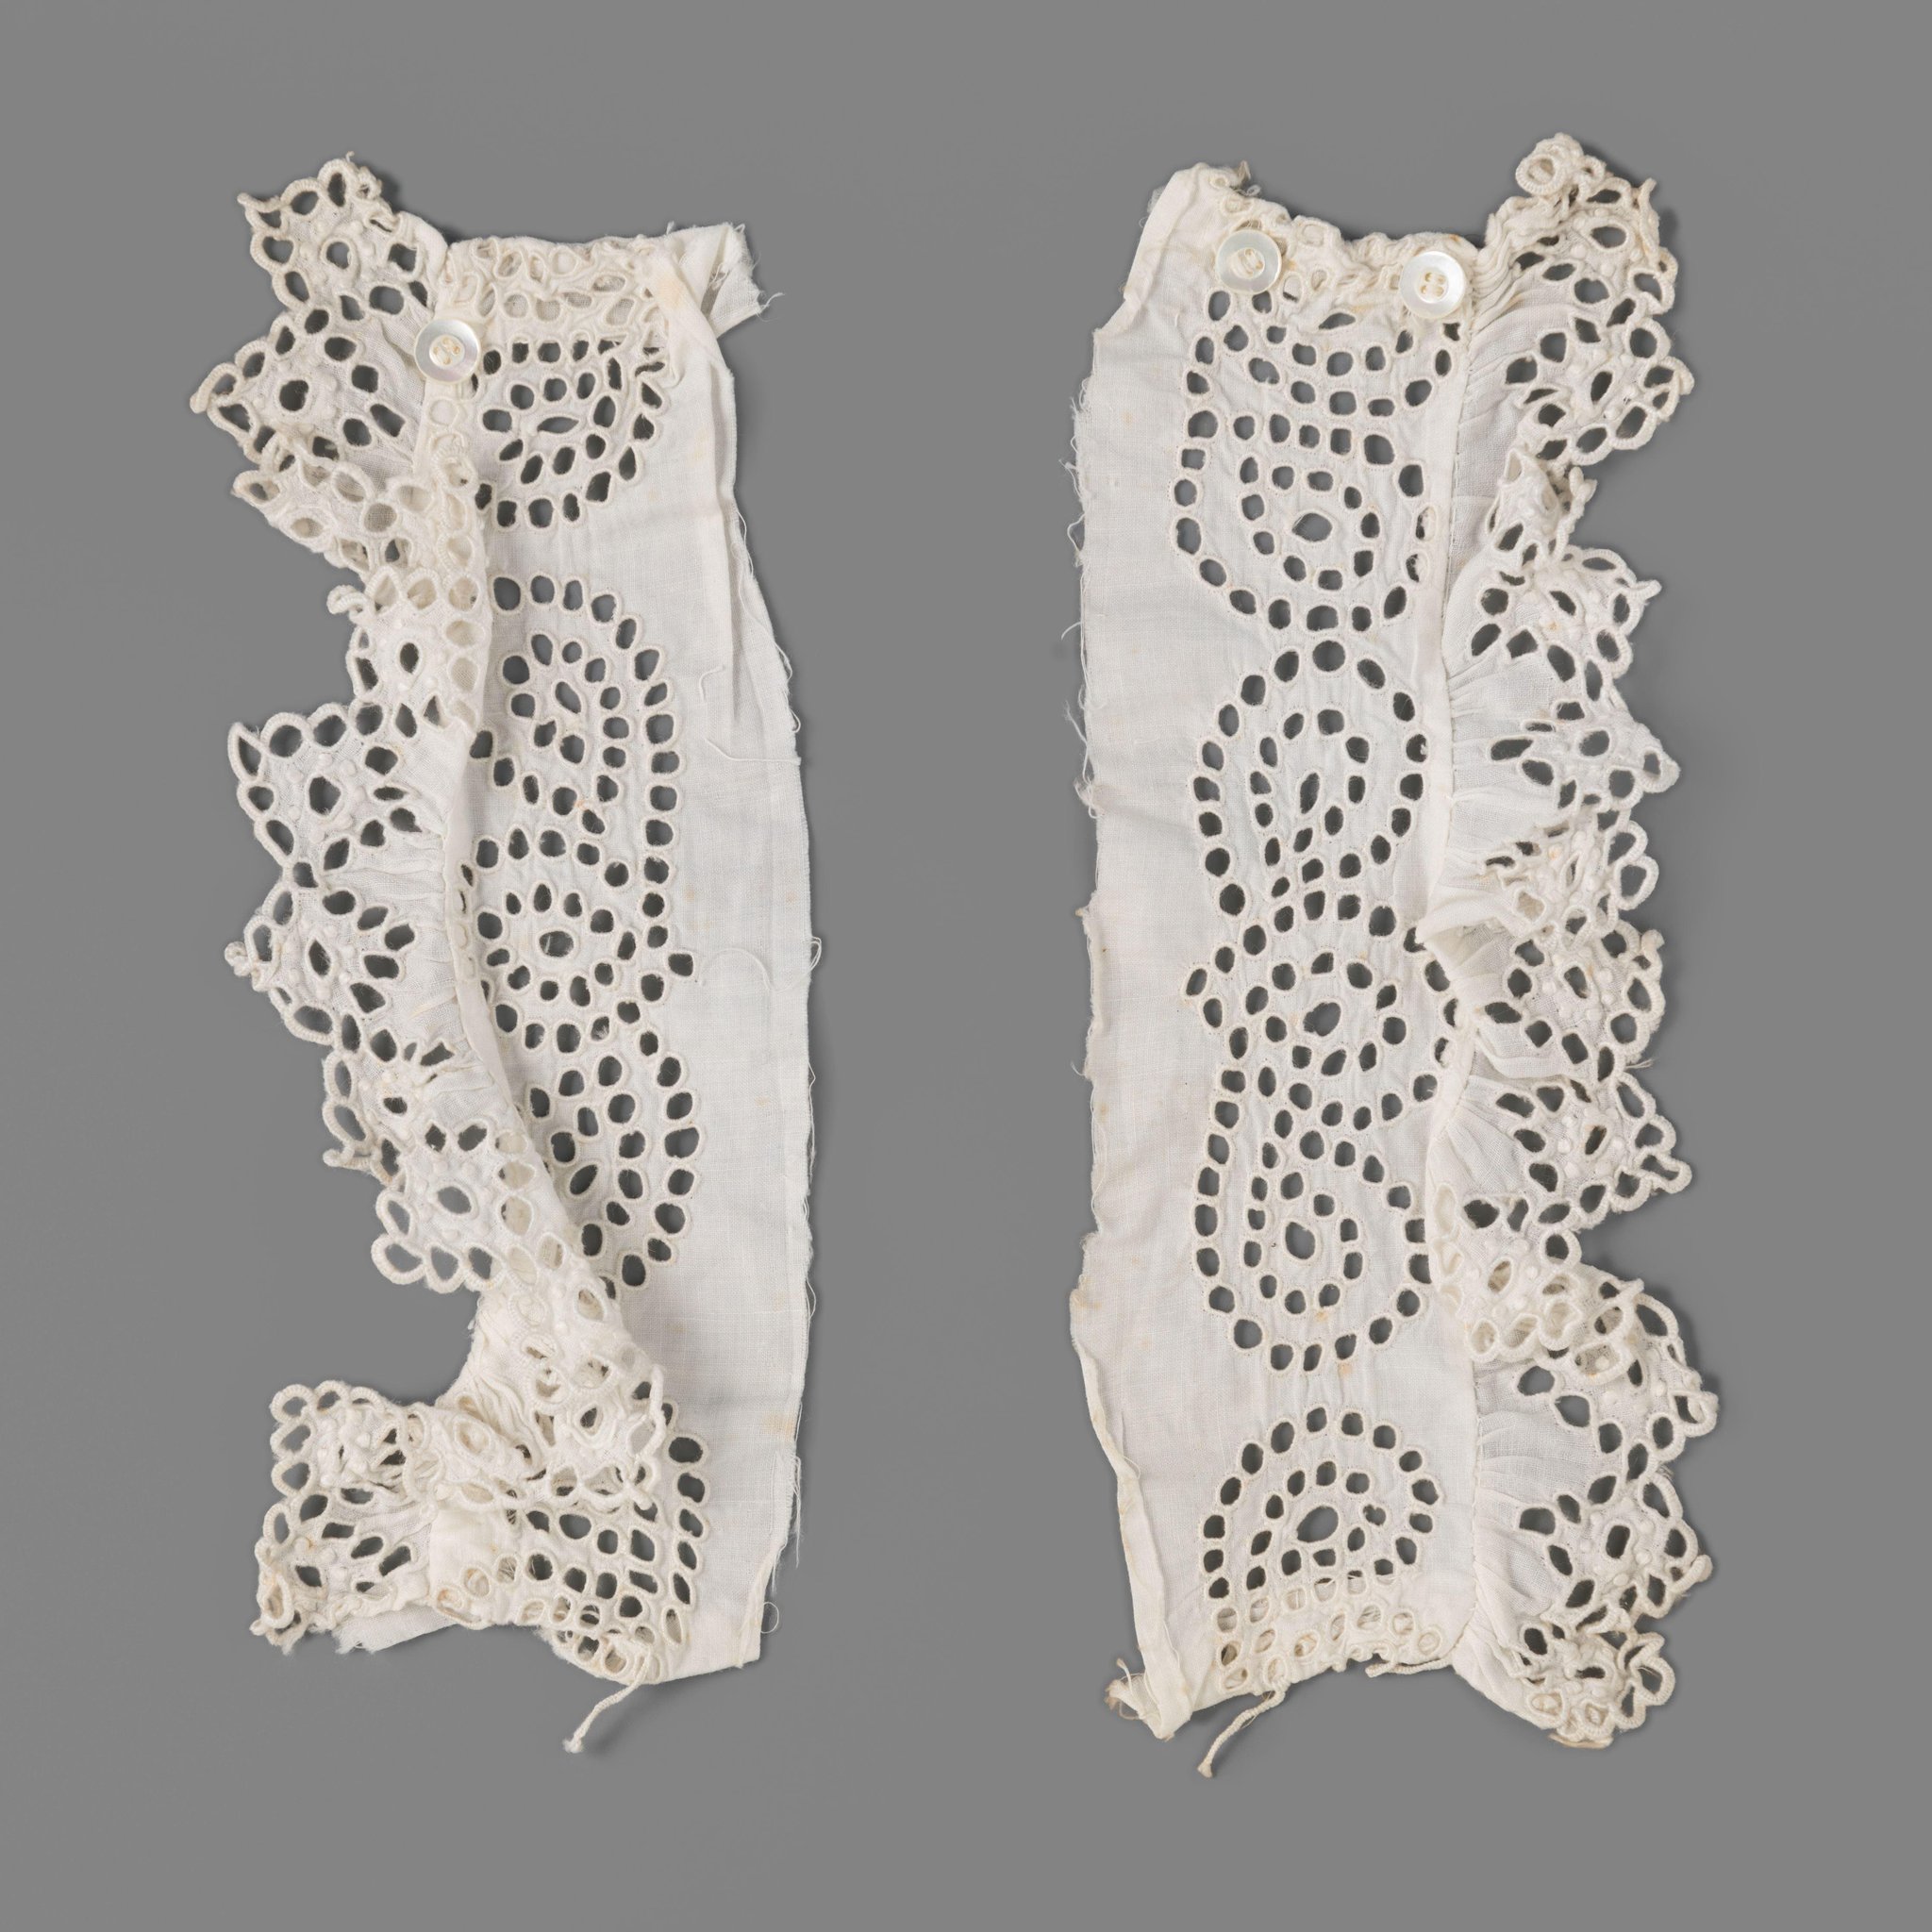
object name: clothing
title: Manchet van Engels borduurwerk met spitse gerimpeld aangezette schulpenstrook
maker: Anonymous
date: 1700-1850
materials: linen, mother of pearl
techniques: cockled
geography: netherlands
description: Manchet van Engels borduurwerk met spitse gerimpeld aangezette schulpenstrook.